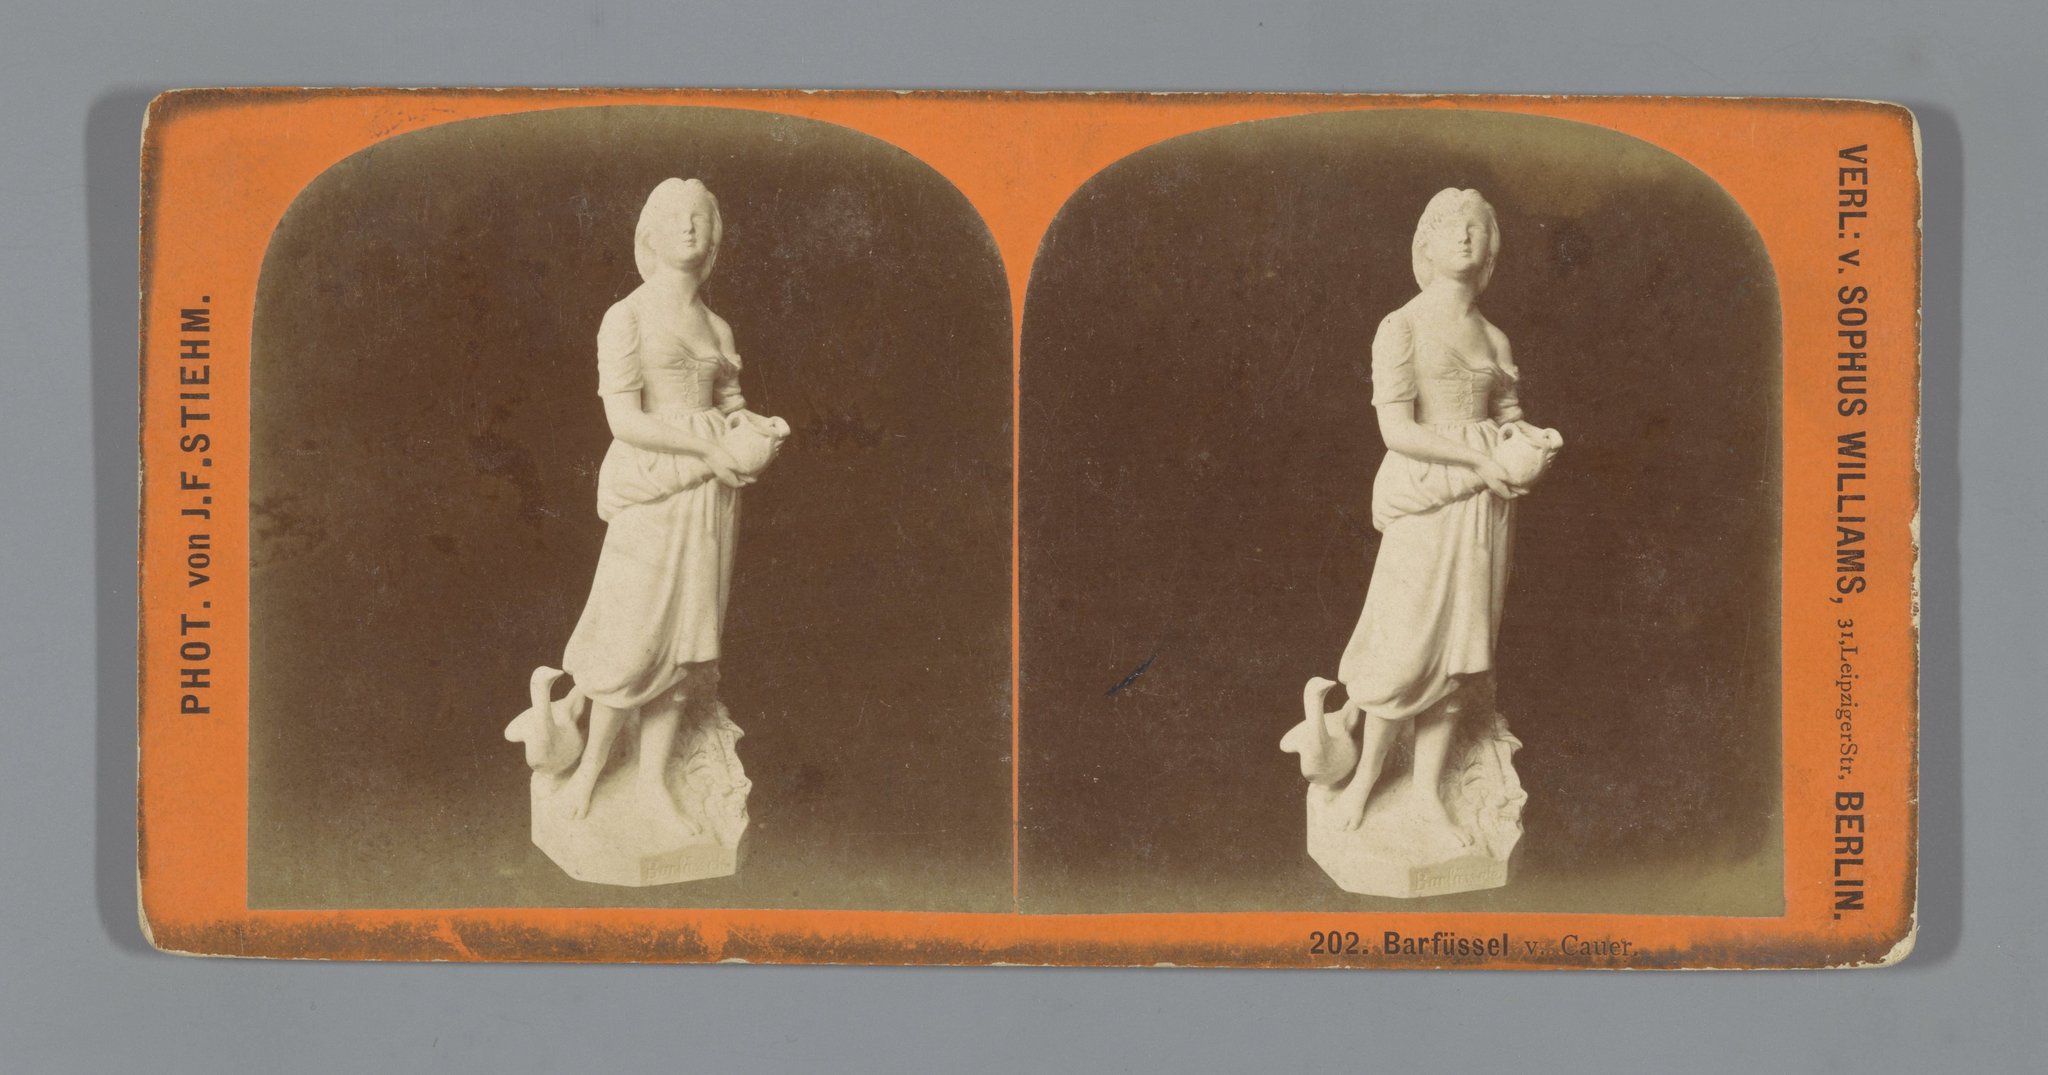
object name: stereograph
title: Barfüssel v. Cauer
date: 1855-1890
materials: cardboard, photographic support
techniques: albumen print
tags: sculptor, tales and fairy tales, sculpture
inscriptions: : ‘31. Leipziger Str. Berlin’, number: ‘202’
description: Sculptuur van de Duitse beeldhouwer Robert Cauer.